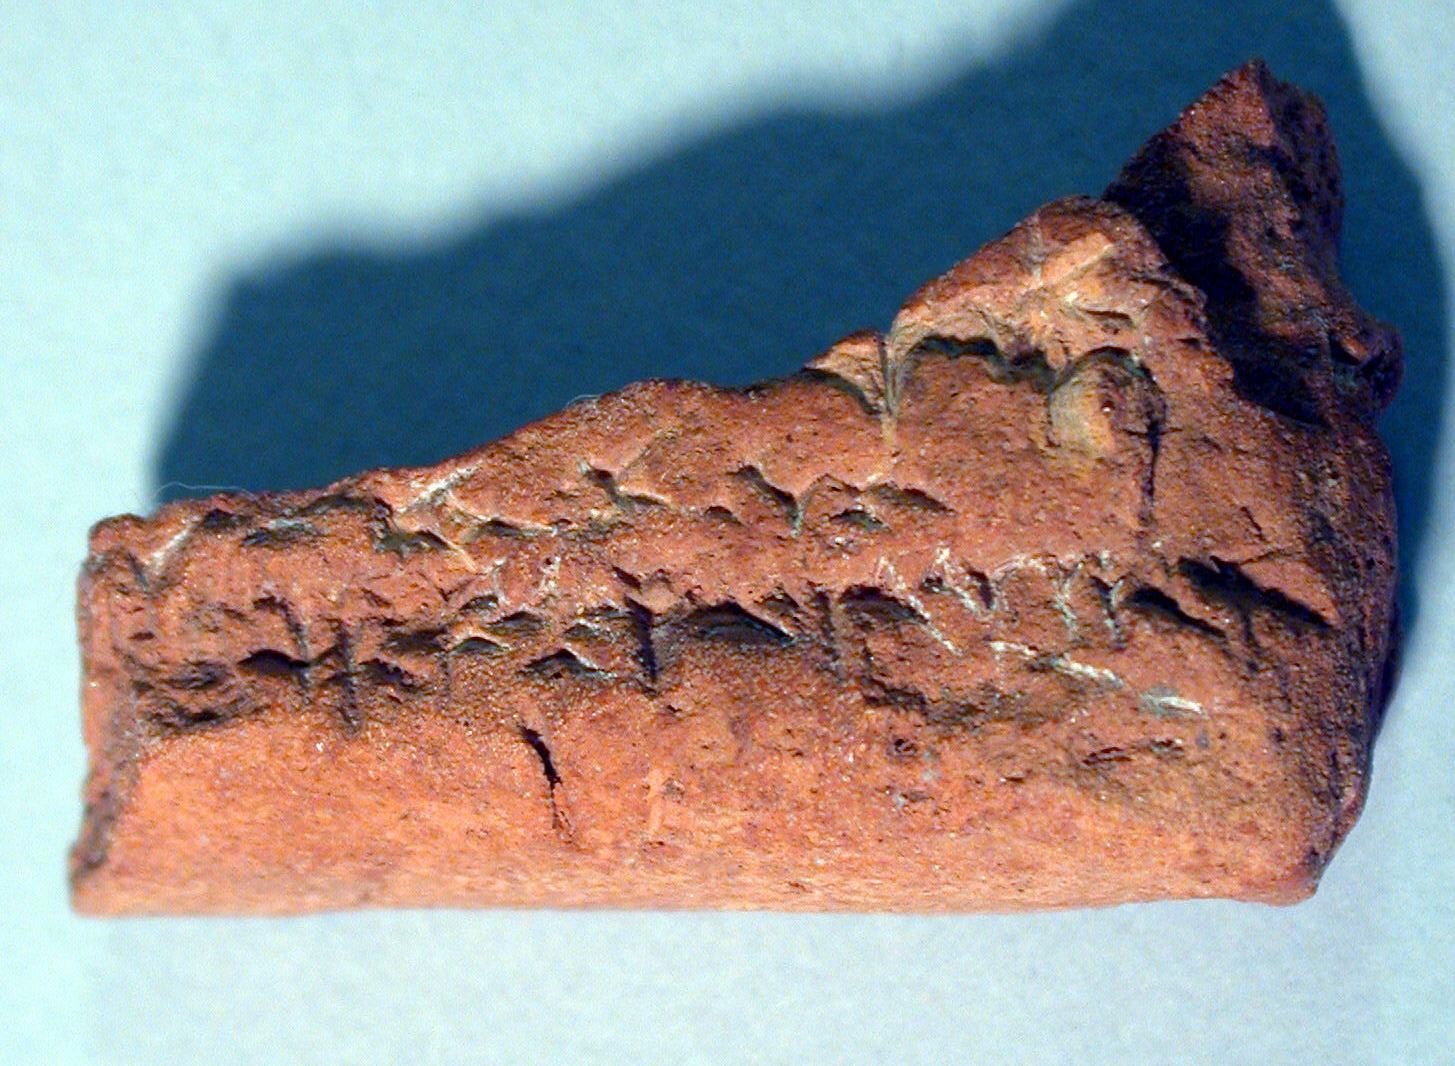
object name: cuneiform tablet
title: Cuneiform tablet: fragment, content uncertain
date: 333-1 BCE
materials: clay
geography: mesopotamia